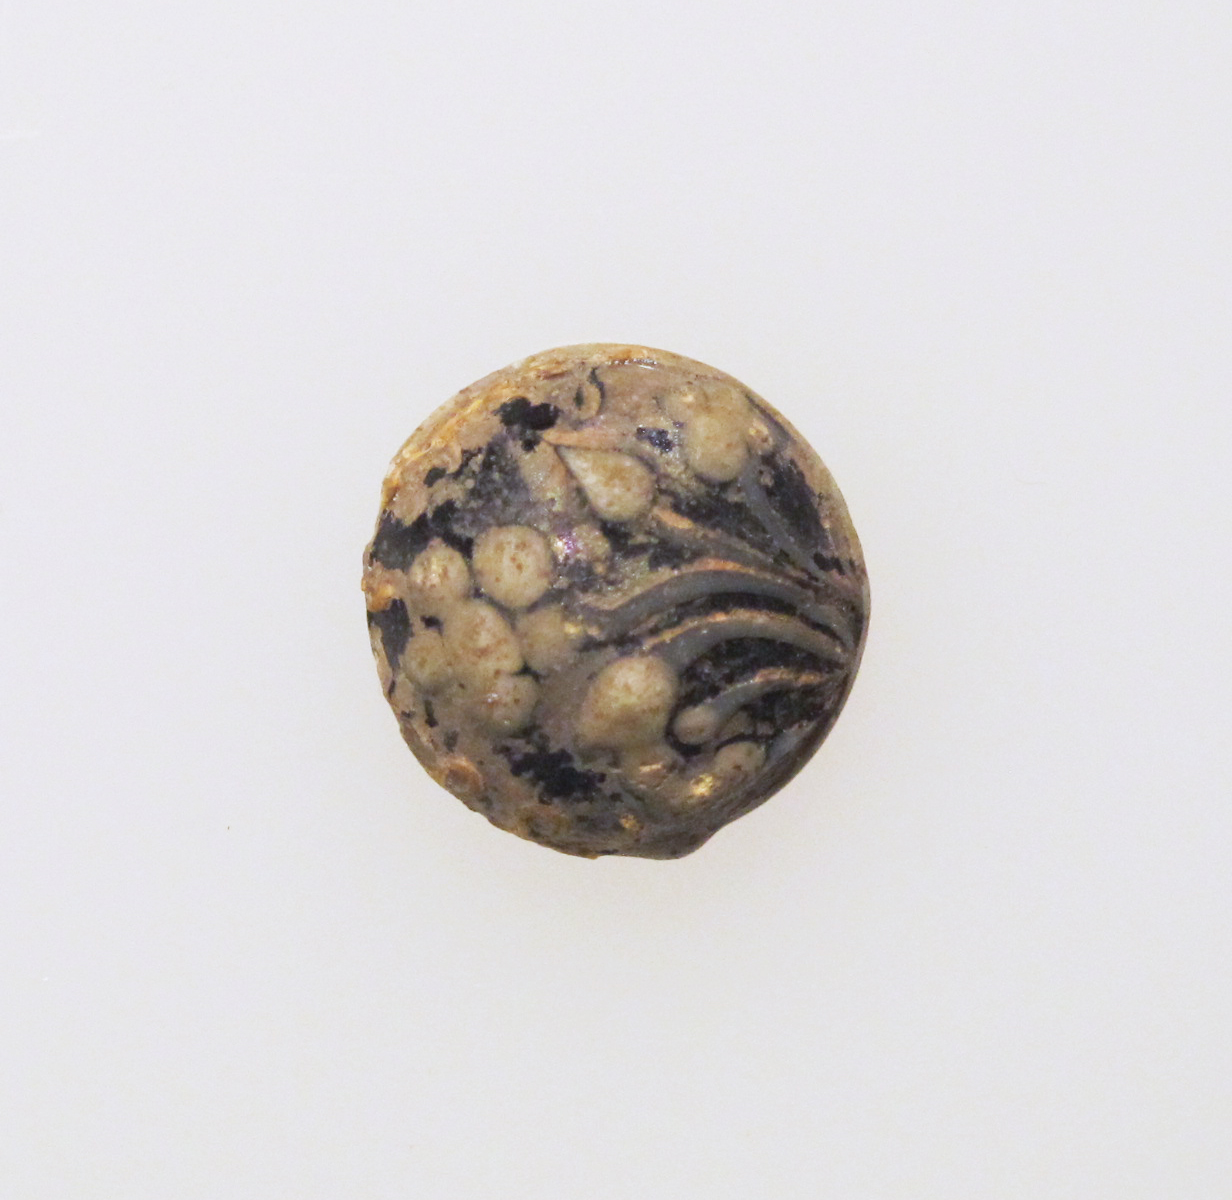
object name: pinhead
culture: roman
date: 670 BCE-330 CE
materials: glass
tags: flowers